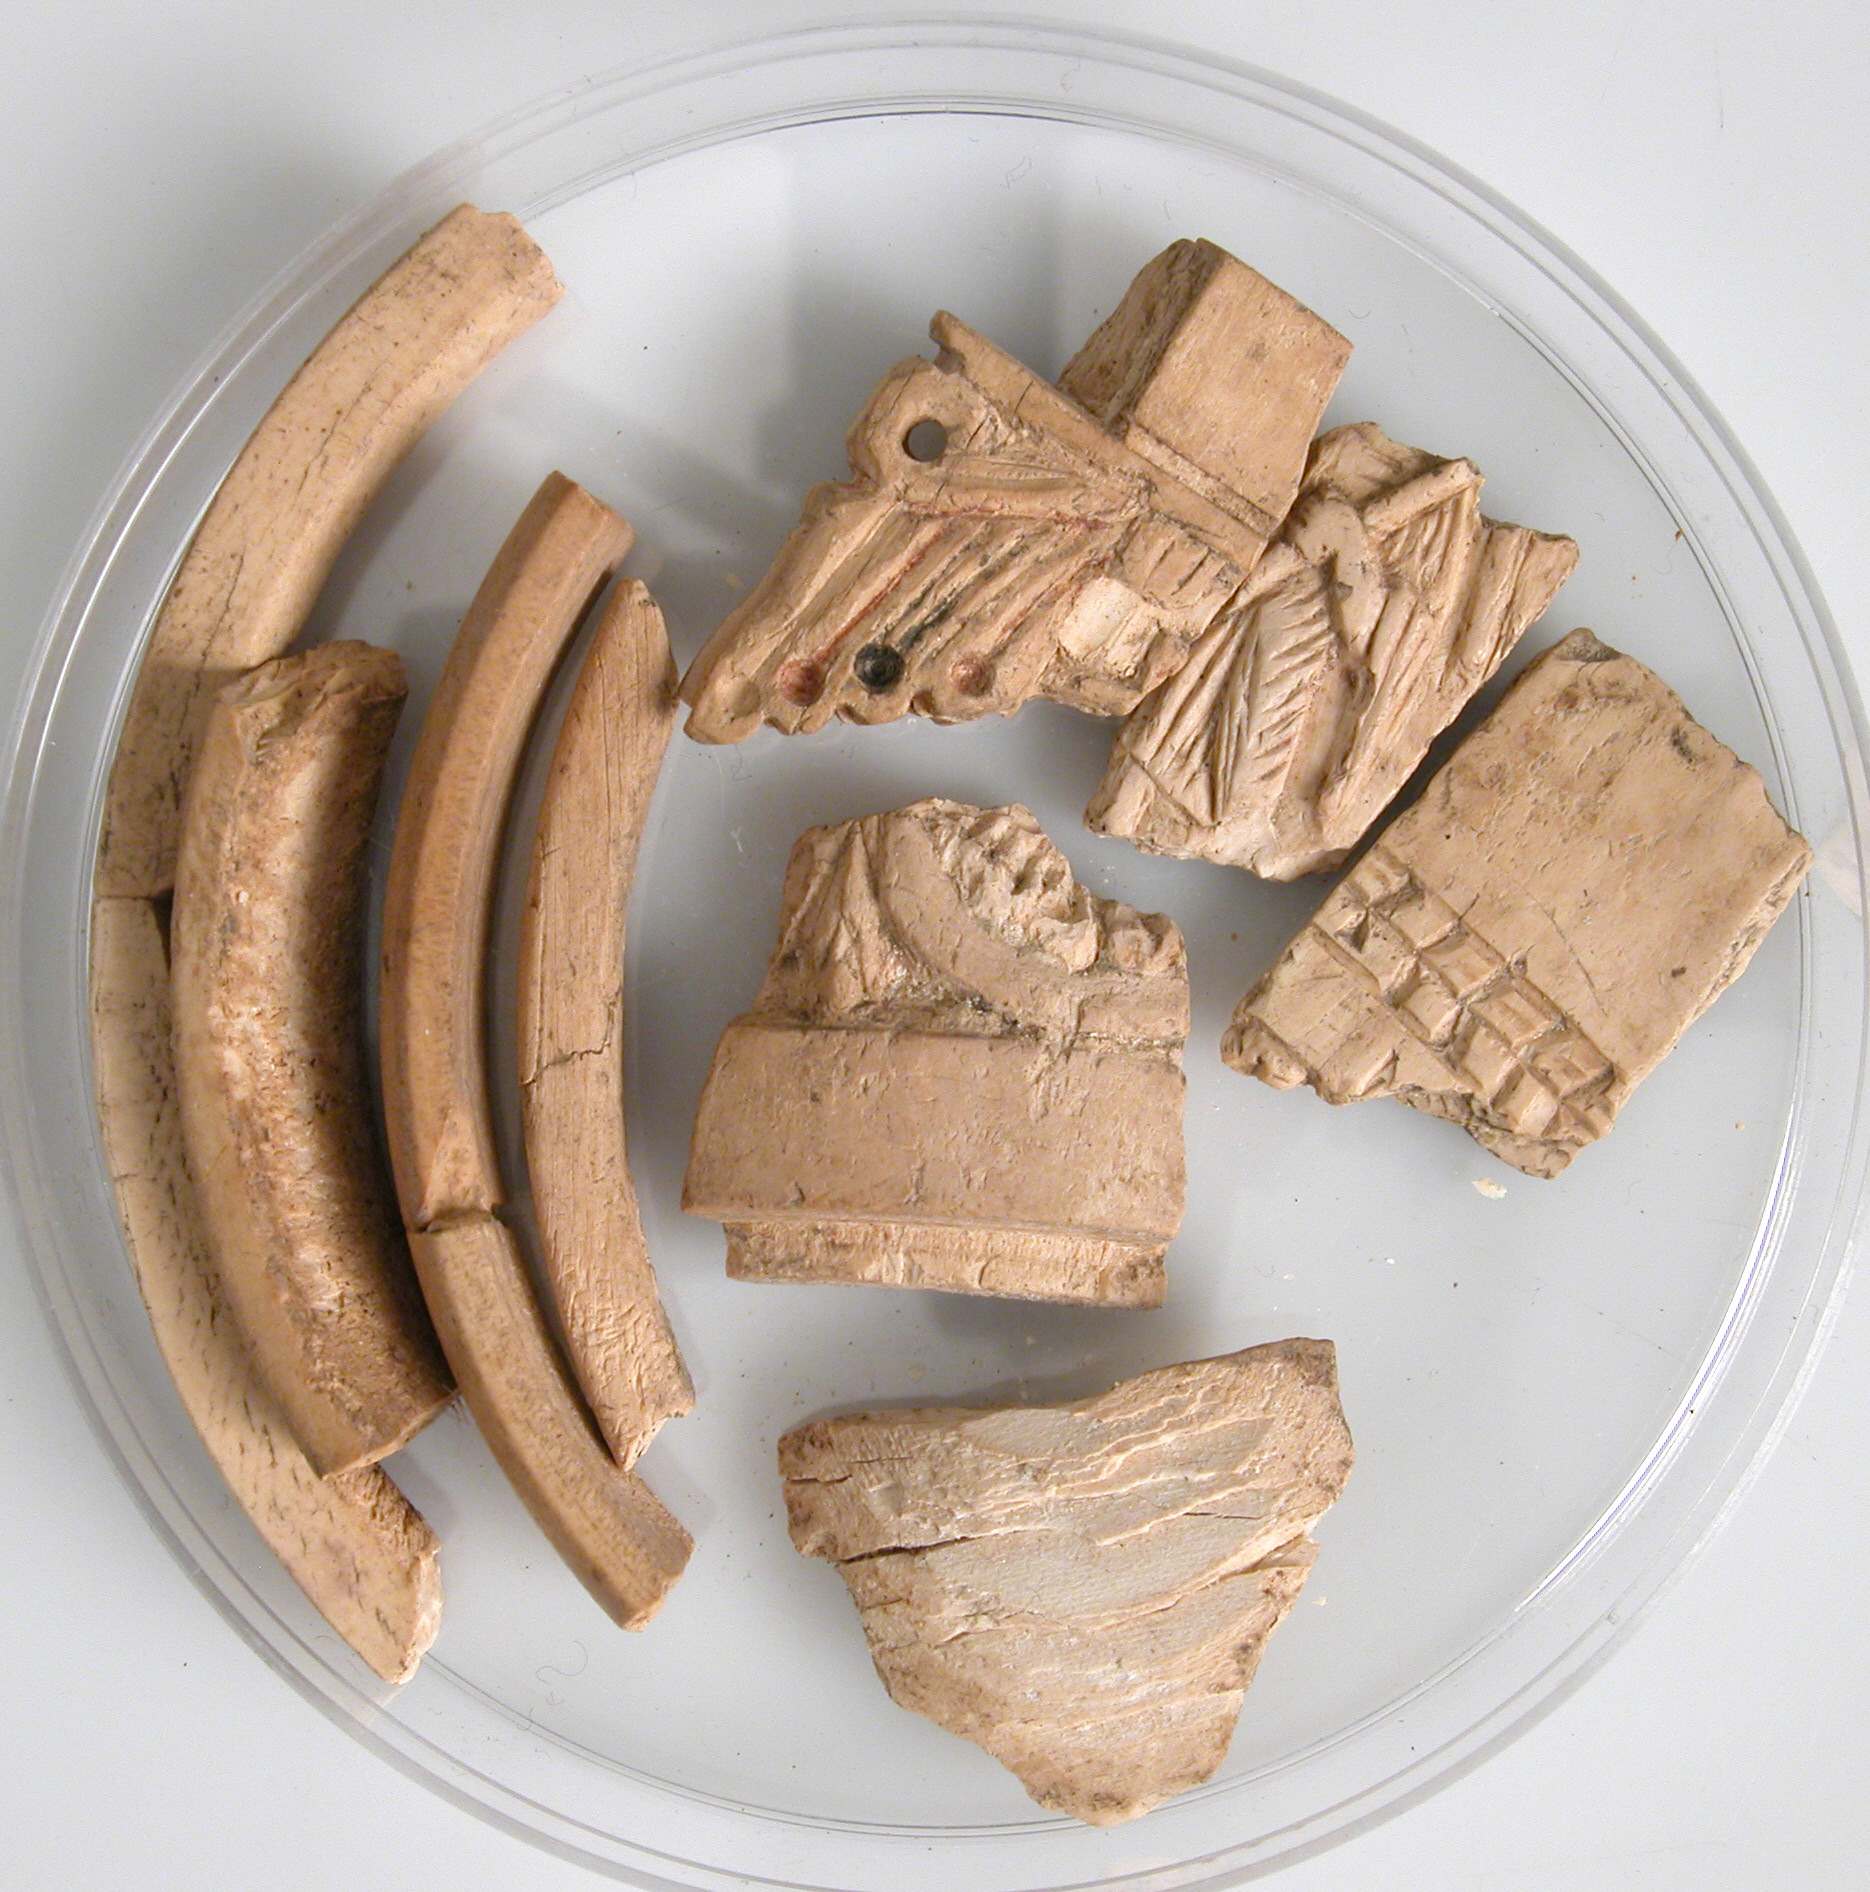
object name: fragment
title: Ivory Fragments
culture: coptic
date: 301-700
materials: ivory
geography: egypt